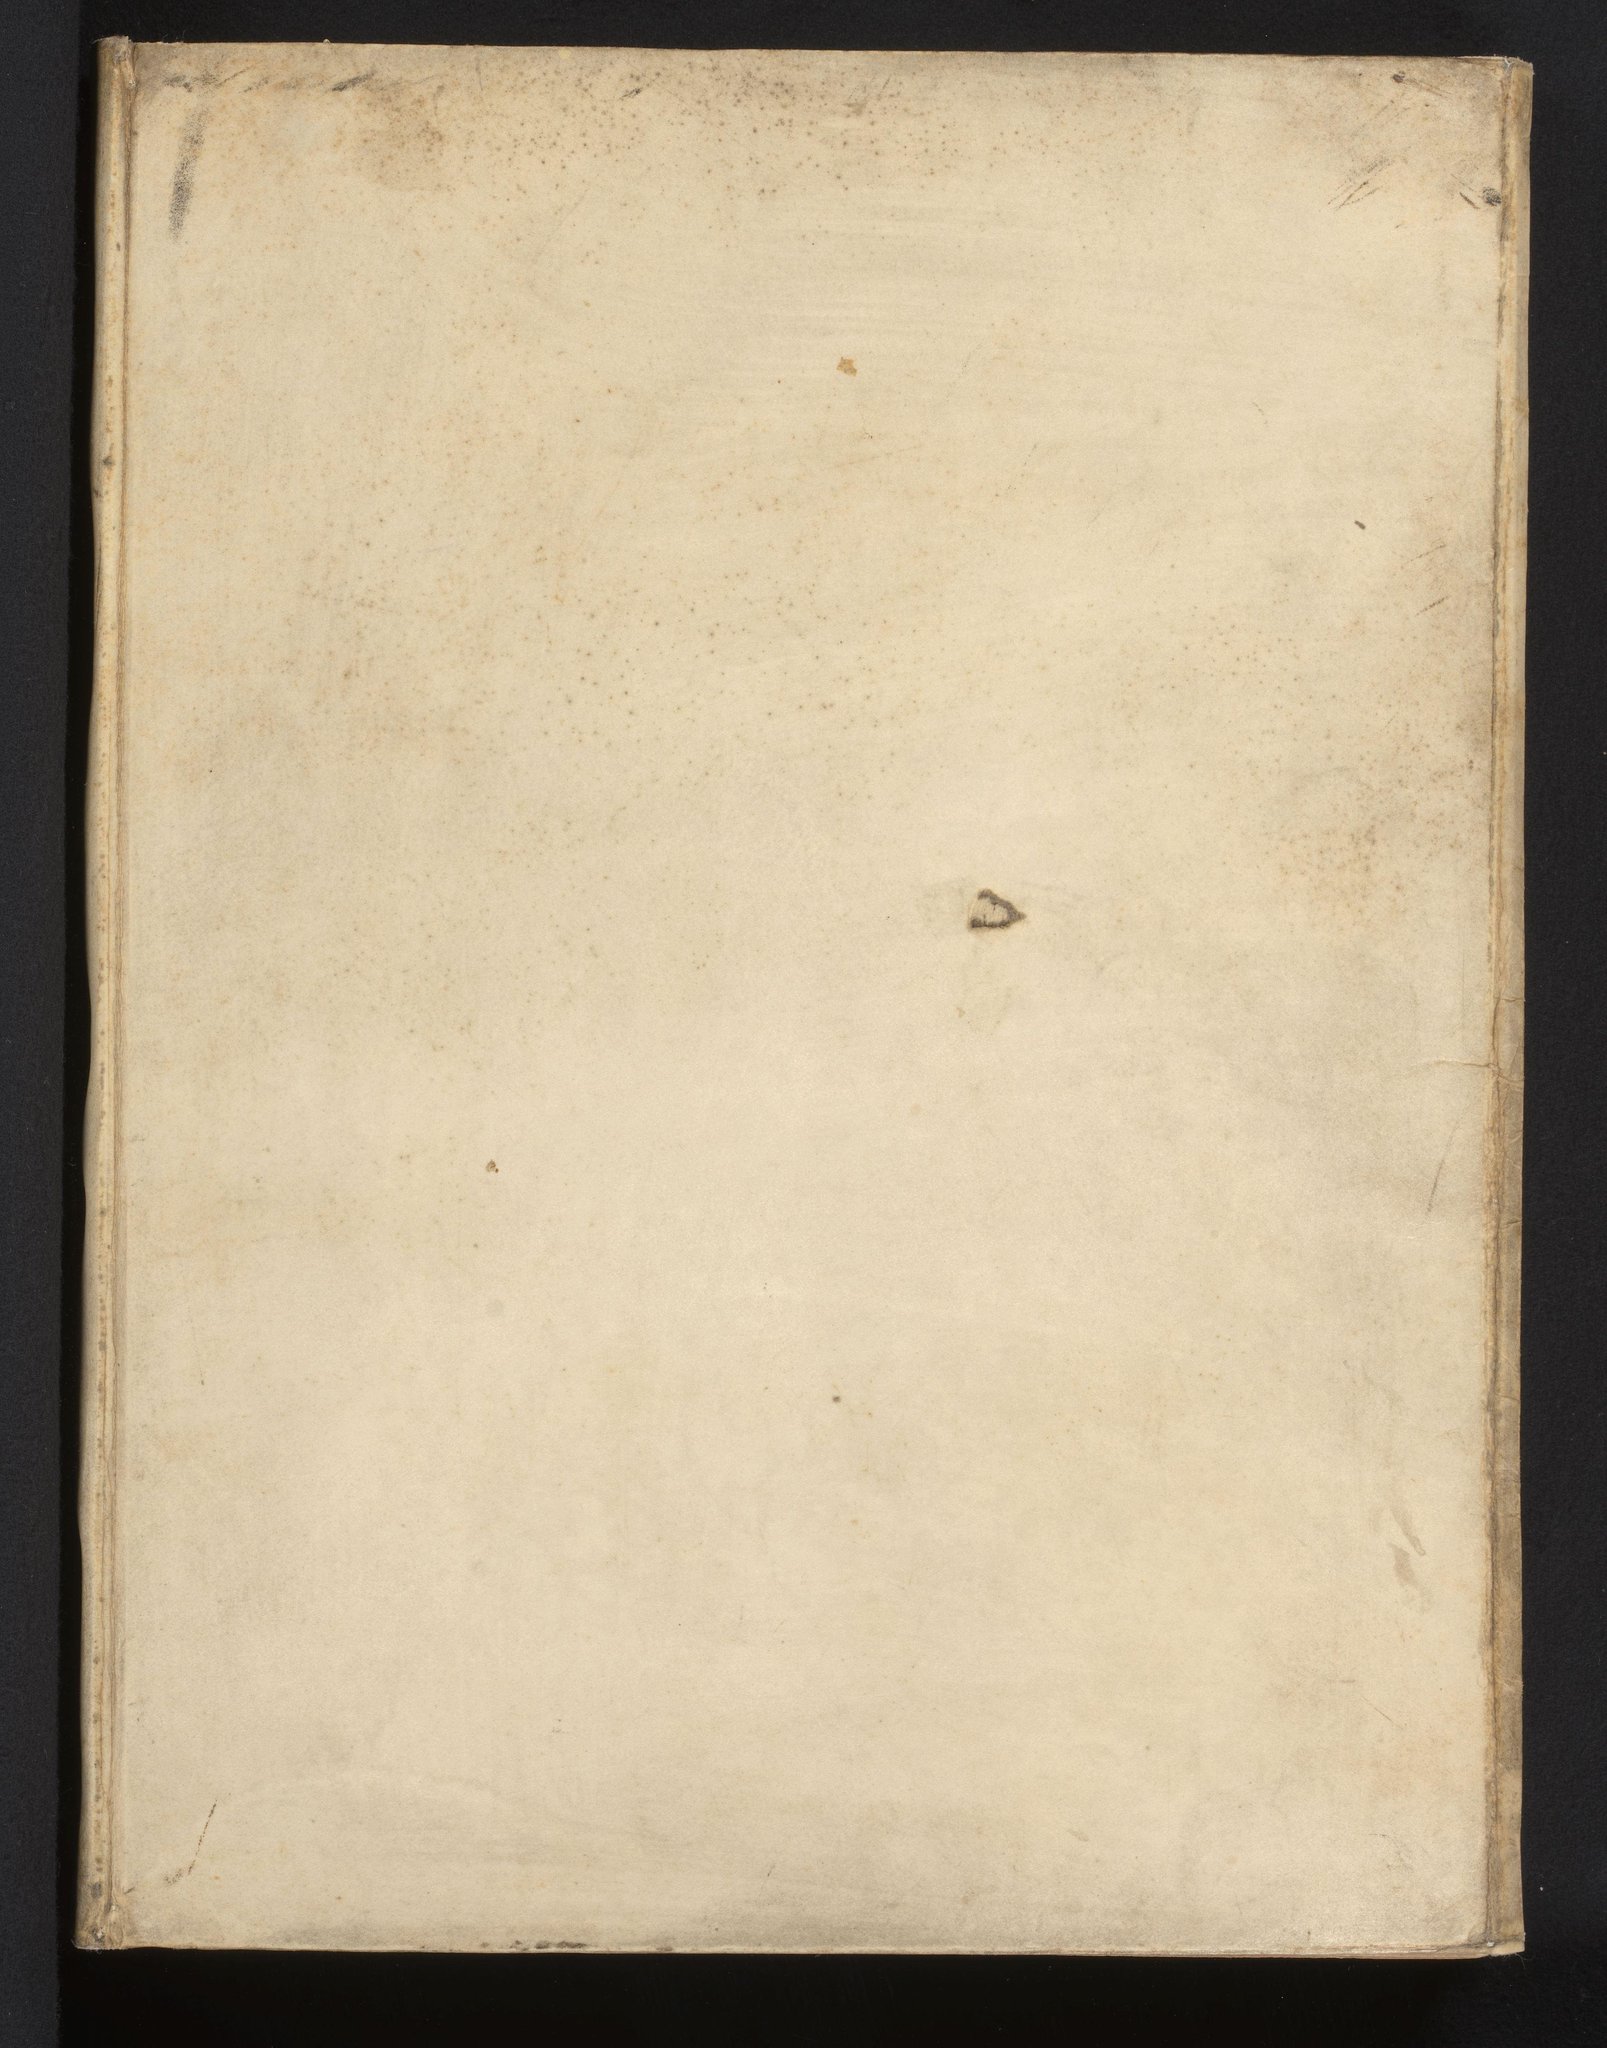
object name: prentrecueil, prentenalbum, prentalbum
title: Album met voorstellingen van figuren in eigentijdse kostuums uit Griekenland, Turkije, Arabië, Perzië en Armenië uit: 'Les quatre premiers livres des navigations et pérégrations orientales' door Nicolas de Nicolay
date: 1555-1568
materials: cardboard, ink, paper, parchment, pencil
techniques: bookbinding, etching, pen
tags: europeans (greeks) (+ costume), asiatic races and peoples: persians (+ costume), africans (+ costume), folk costume, regional costume, asiatic races and peoples: turks (+ costume)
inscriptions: collector's mark: Lugt 2760, collector's mark: Lugt 2228, inscription: ‘Reliée par le S[...] de Petit [...] de Sinnier (?)/ (thierry)’, inscription: ‘Collection complète des 60 planches hors texte gravées/ sur cuivre extraite des Quatre Premiers Livres des/ Navigations et Pérégrinations orientales par N. de Nicolay/ Lyon, 1567 ou 1568, in folio./ Les gravures representent des costumes masculins/ et féminins de la Turquie, de l'Arabie et de la Grèce,/ c'est la première série de documents sérieux sur les/ habillements du proche Orient, aussi a-t-elle été copiée/ par la plupart des dessinateurs d'habits du XVIe siècle/ ces gravures sont attribueés à Louis Danet par la plus/ part des bibliographes. Cependant l'exemplaire du Cabinet/ des Estampes porte en note manuscrite que ces planches/ sont graveés par Léonard Thiry dit Léonard Daven/ confirment cette dernière attributionn./ Brunet, IV.67./ Prix avant 1918.: 250 à 500.’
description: Prenten uit: Nicolay, Nicolas de. Les quatre premiers livres des navigations et pérégrinations orientales, de N. de Nicolay, (...) Avec les figures au naturel tant d'hommes que de femmes selon la diversité des nations, & de leur port, maintien & habitz. Lyon: Guillaume (I) Rouille, 1568. De tekst door De Nicolay werd vervolgens uitgegeven in 1576 te Antwerpen dor Guillaumde Silvius in verschillende talen, vergezeld door zestig houtsneden naar de prenten door Léon Davent. Een latere Italiaanse editie uit 1580, vertaald door Francesco Flori da Lillo en uitgegeven door Francesco Ziletti in Venetië wordt vergezeld door gravures naar de etsen van Léon Davent. Deze anonieme prentmaker voegde zeven prenten toe aan de reeks, mogelijk naar tekeningen door De Nicolay of door Luca Penni.